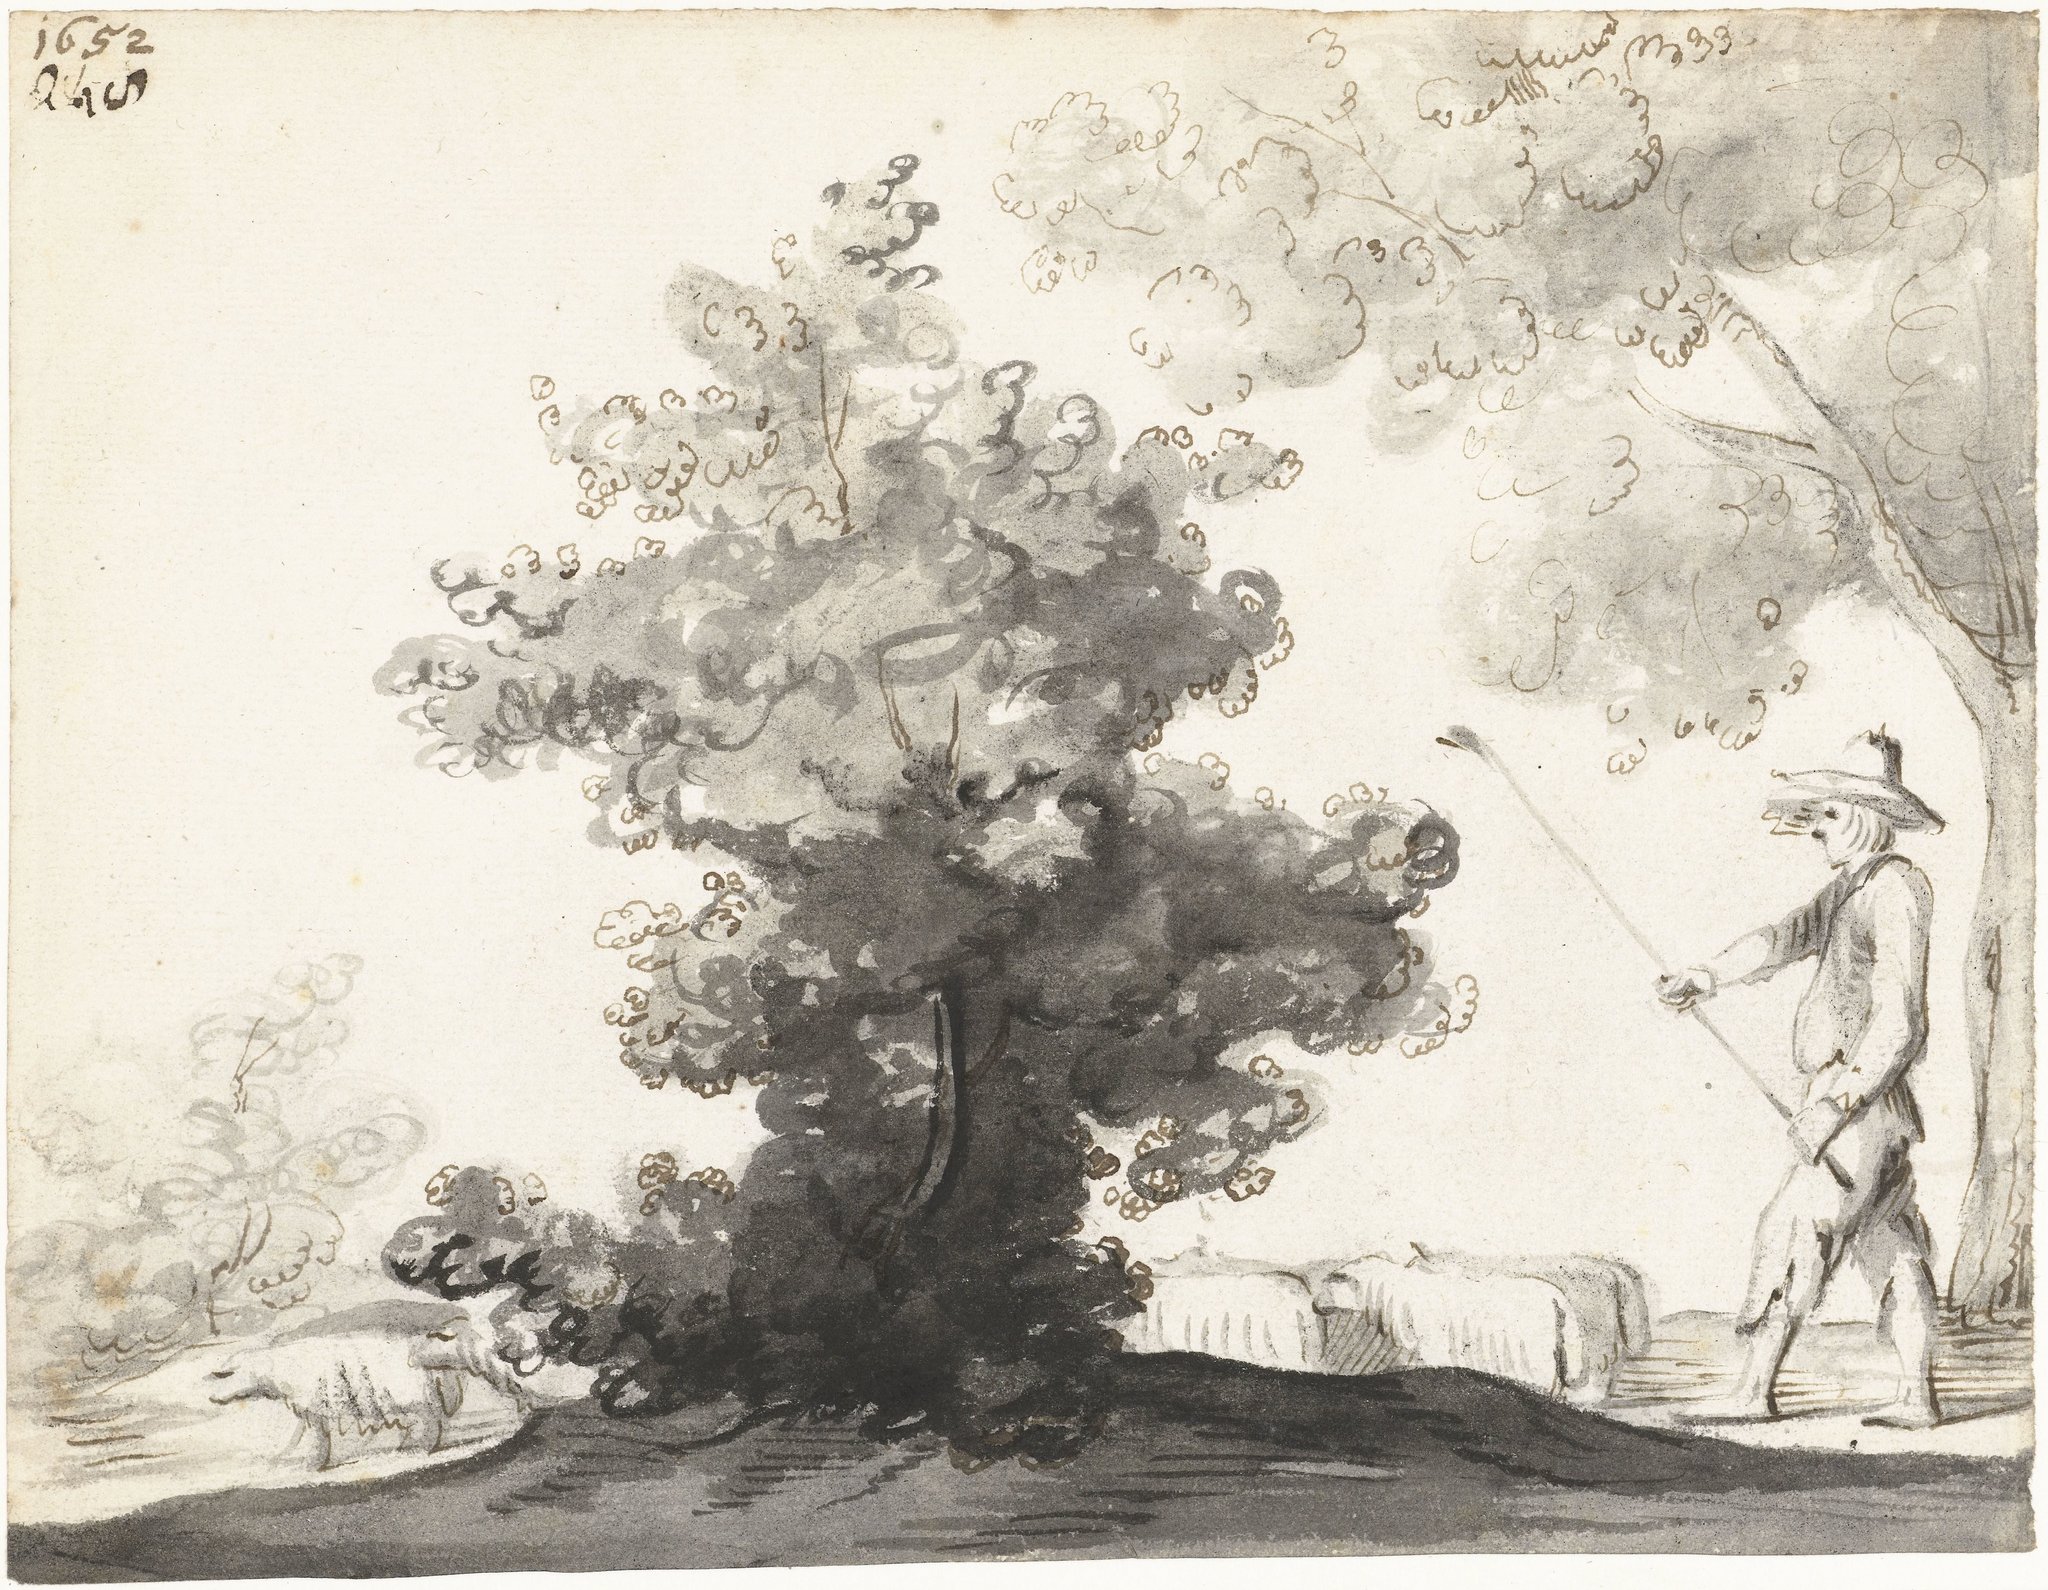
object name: drawing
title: Herder met staf en schapen, lopend langs een struik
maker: harmen ter borch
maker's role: draughtsman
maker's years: 1638-1677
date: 1652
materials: chalk, ink, paper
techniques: brush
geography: zwolle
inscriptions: annotation: ‘1652’